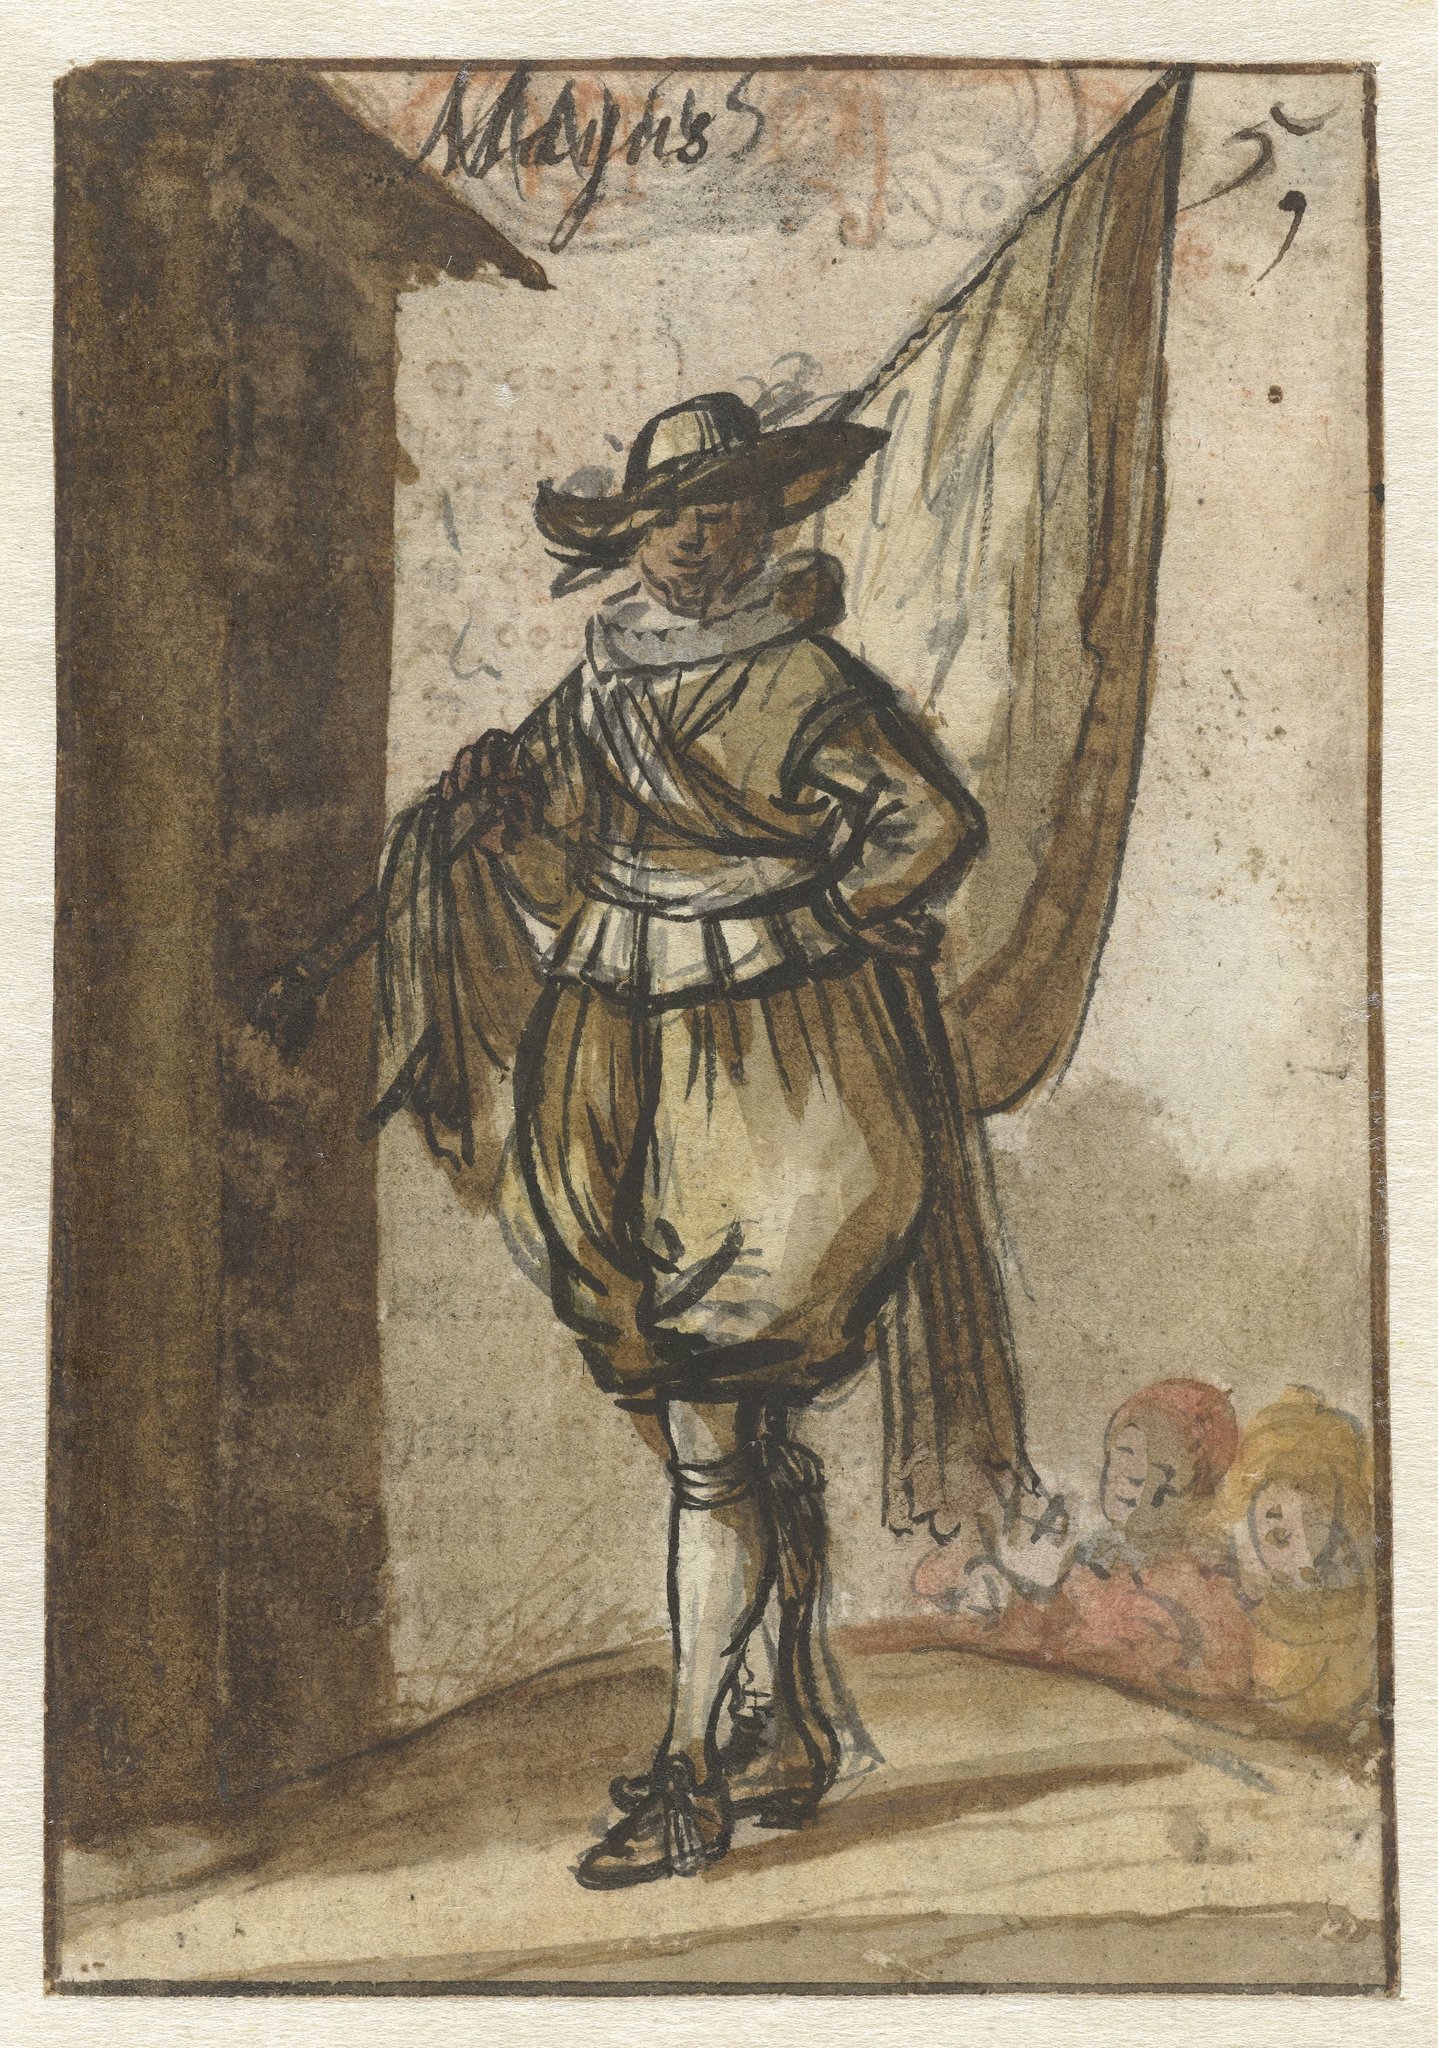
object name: drawing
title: De twaalf maanden van het jaar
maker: Anonymous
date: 1600-1699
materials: paper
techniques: brush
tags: may and its 'labours', (military) standard-bearer